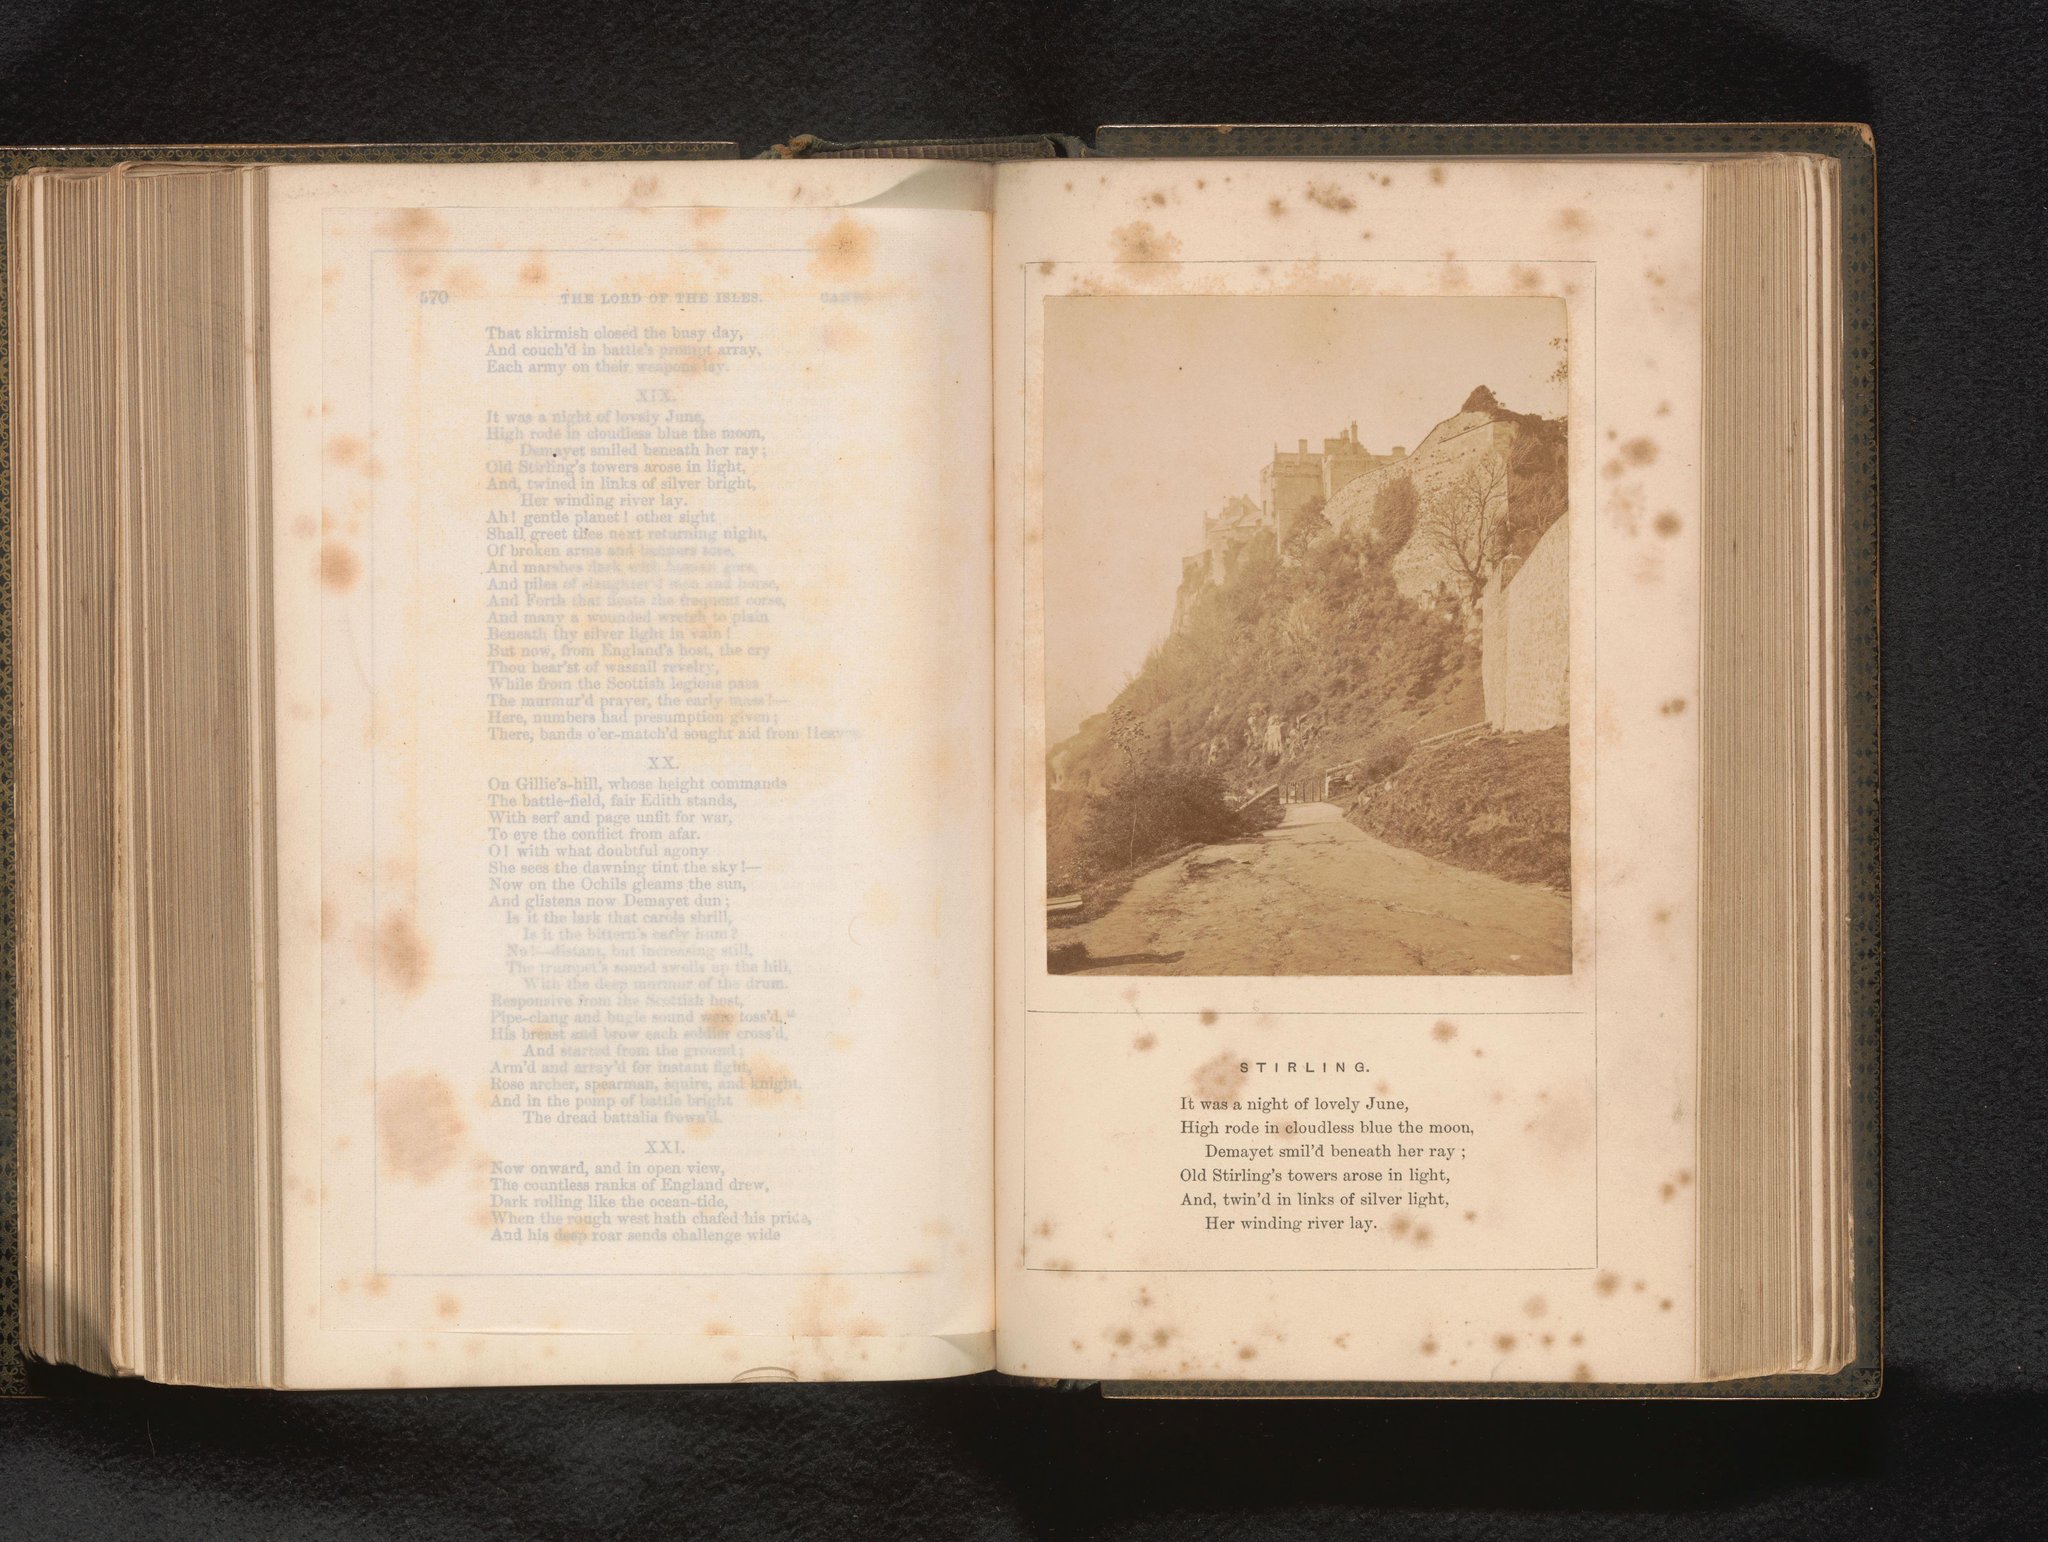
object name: photograph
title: Gezicht op Stirling Castle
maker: Anonymous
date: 1858-1868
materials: photographic support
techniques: albumen print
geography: stirling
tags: castle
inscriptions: inscription: ‘It was a night of lovely June, High rode in cloudless blue the moon (...)’